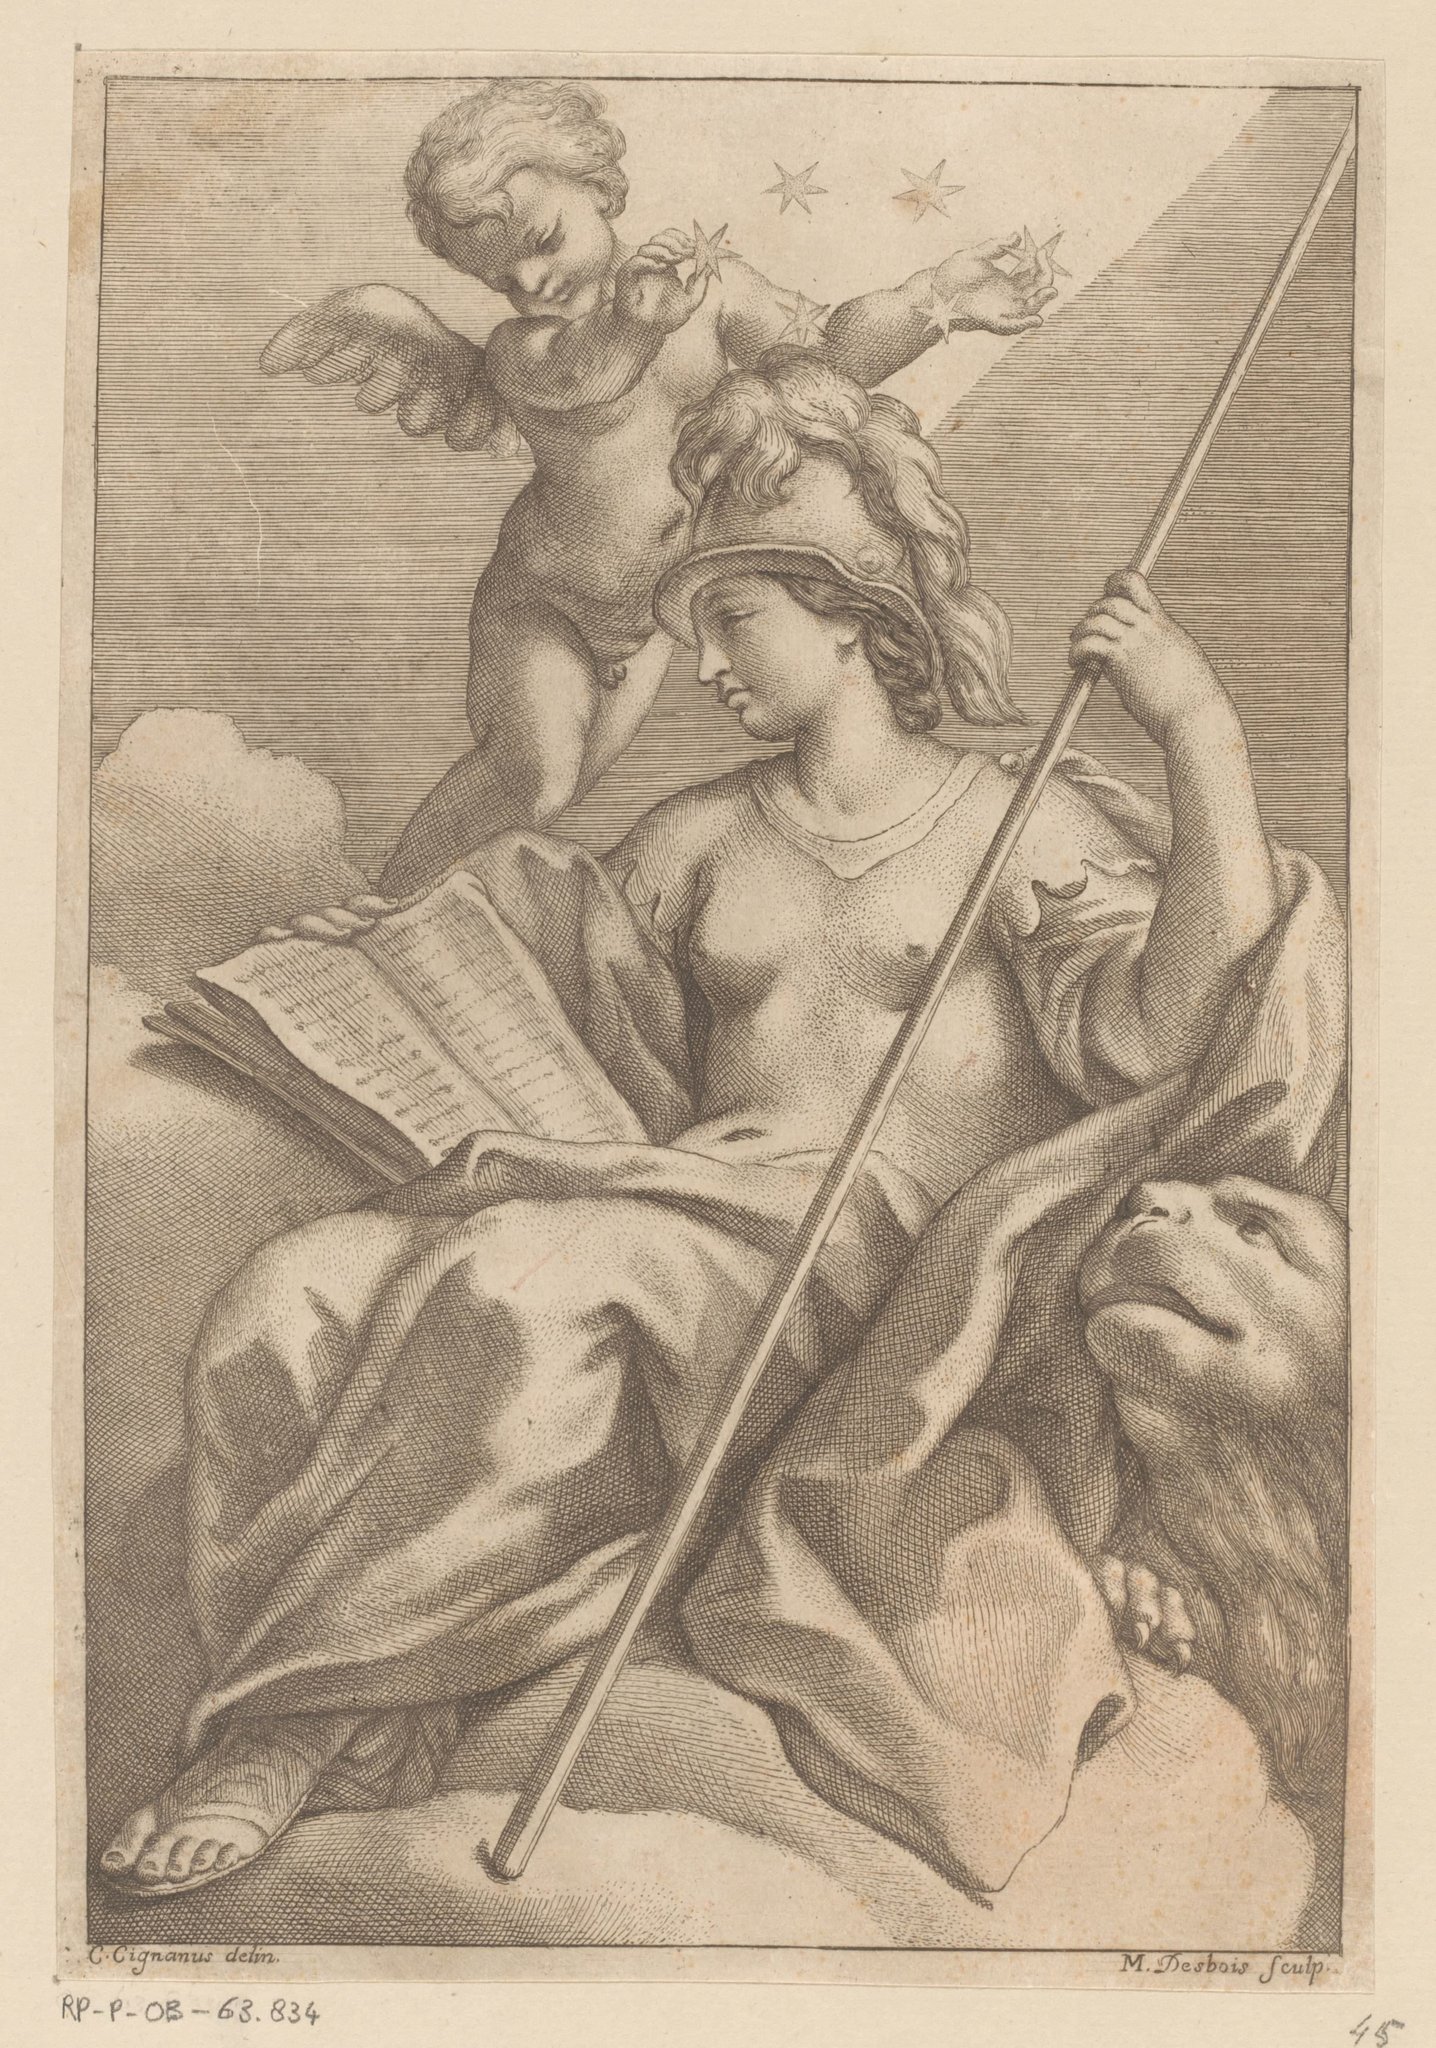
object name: print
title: Personificatie van Venetië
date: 1640-1700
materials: paper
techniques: engraving, etching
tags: personification of a city, town-patron(ess), cupids: 'amores', 'amoretti', 'putti', venice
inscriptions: collector's mark: Lugt 240